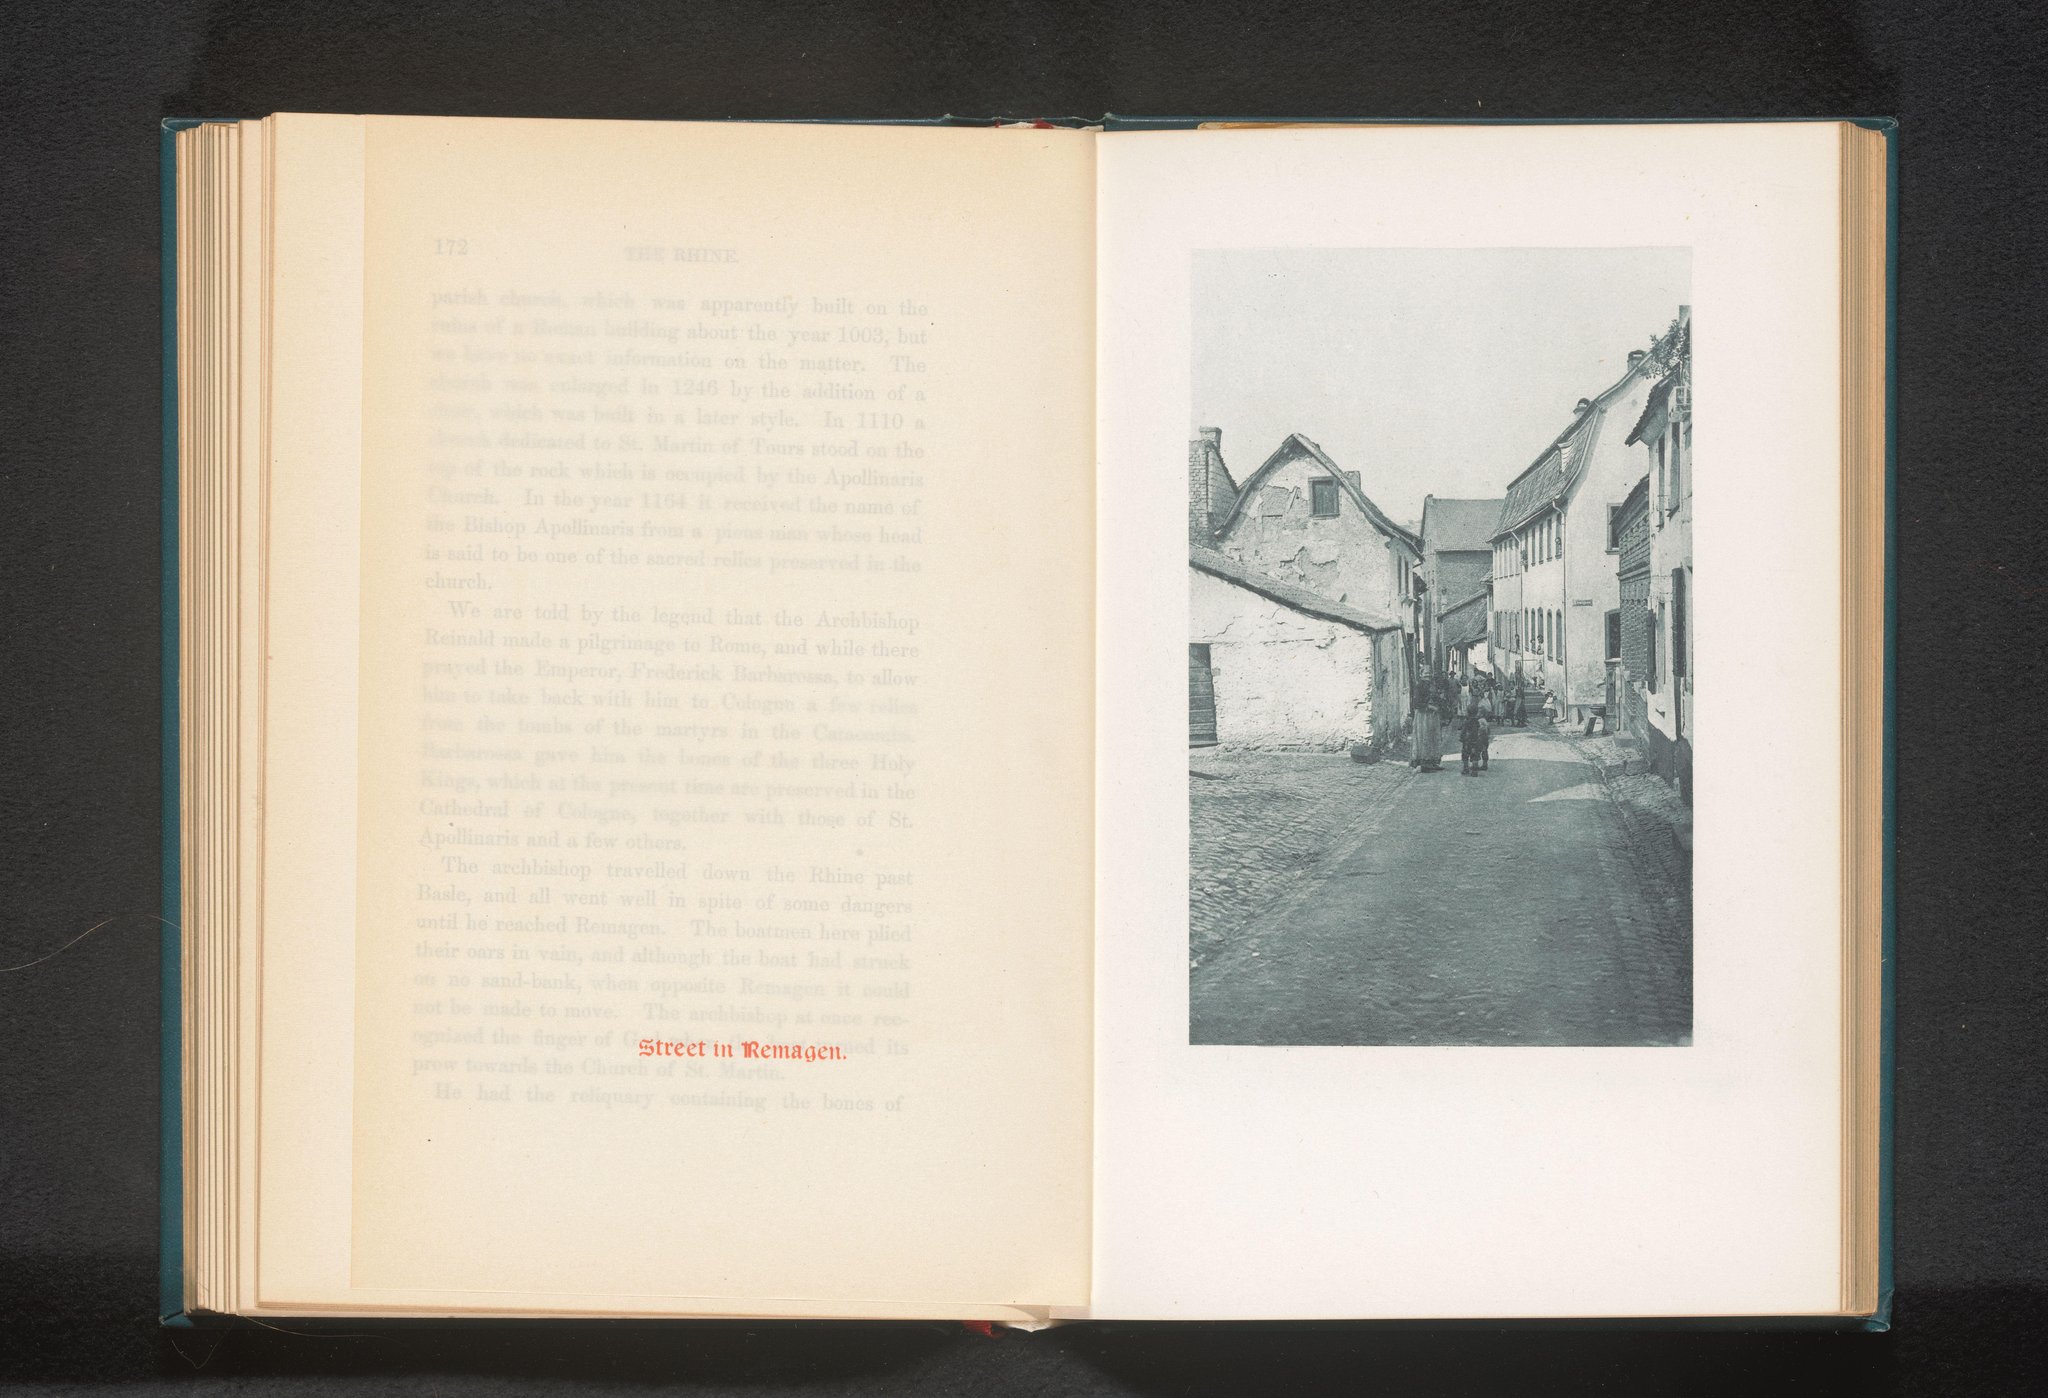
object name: photomechanical print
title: Gezicht op Linz am Rhein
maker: Anonymous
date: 1889-1899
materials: paper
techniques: photoaquatint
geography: rhine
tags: city-view in general; 'veduta'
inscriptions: title: ‘Linz on the Rhine.’